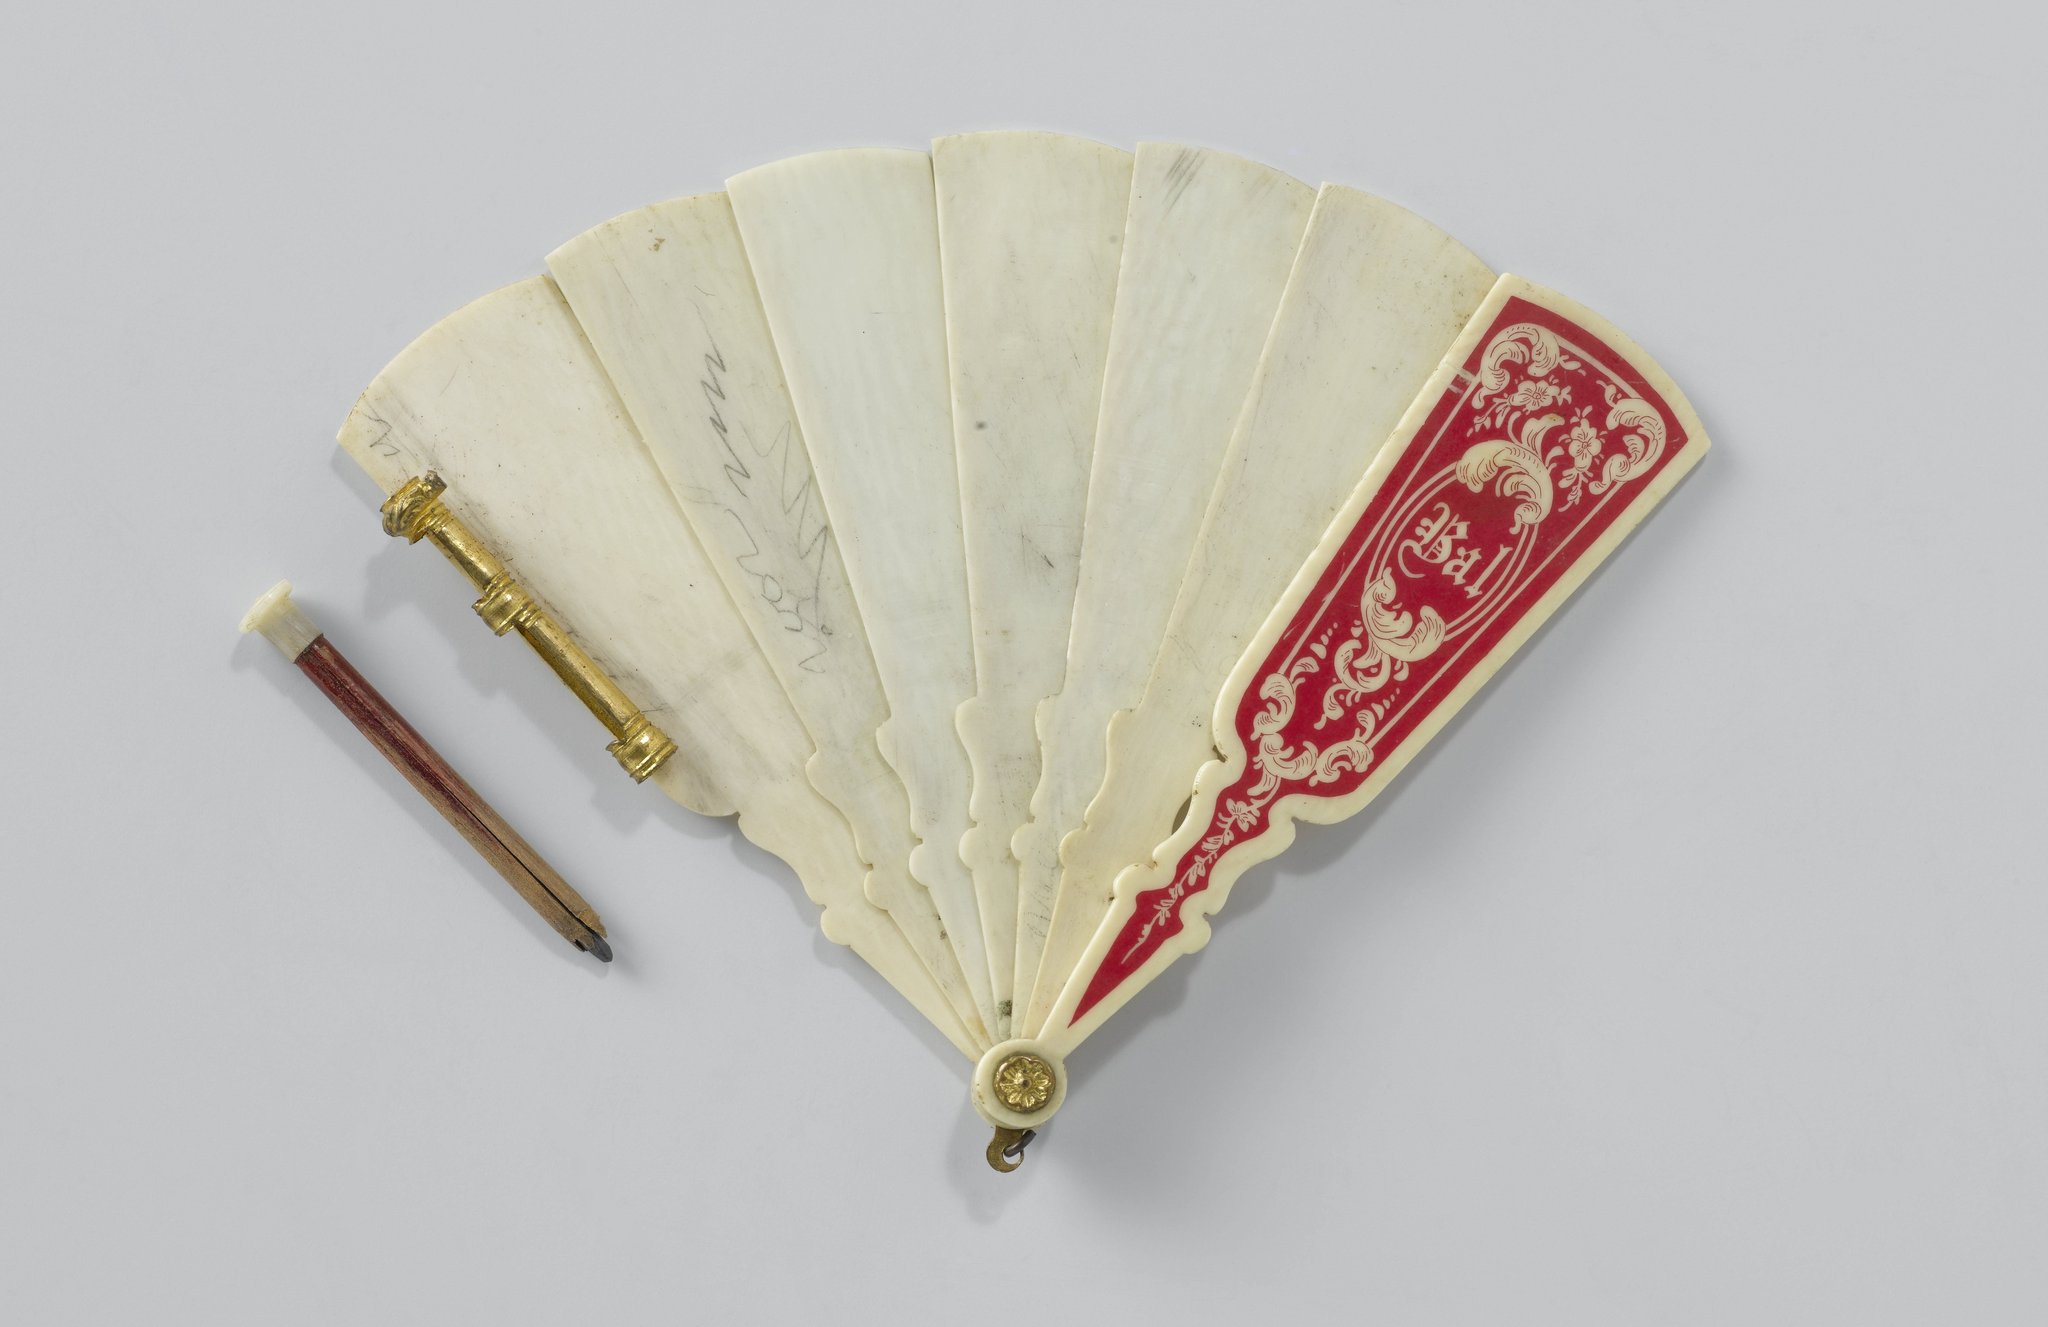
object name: brisé fan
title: Balboekje van ivoor in de vorm van een brisé-waaier, met potloodje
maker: Anonymous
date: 1890-1900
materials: copper, graphite, ivory, wood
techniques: casting, cutting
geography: netherlands